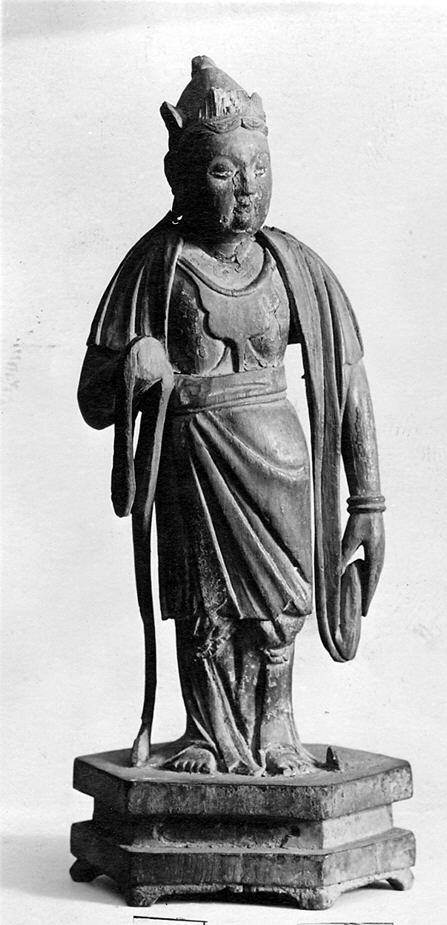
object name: statuette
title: Statuette of Bodhisattva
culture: chinese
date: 1368-1644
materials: wood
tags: bodhisattvas